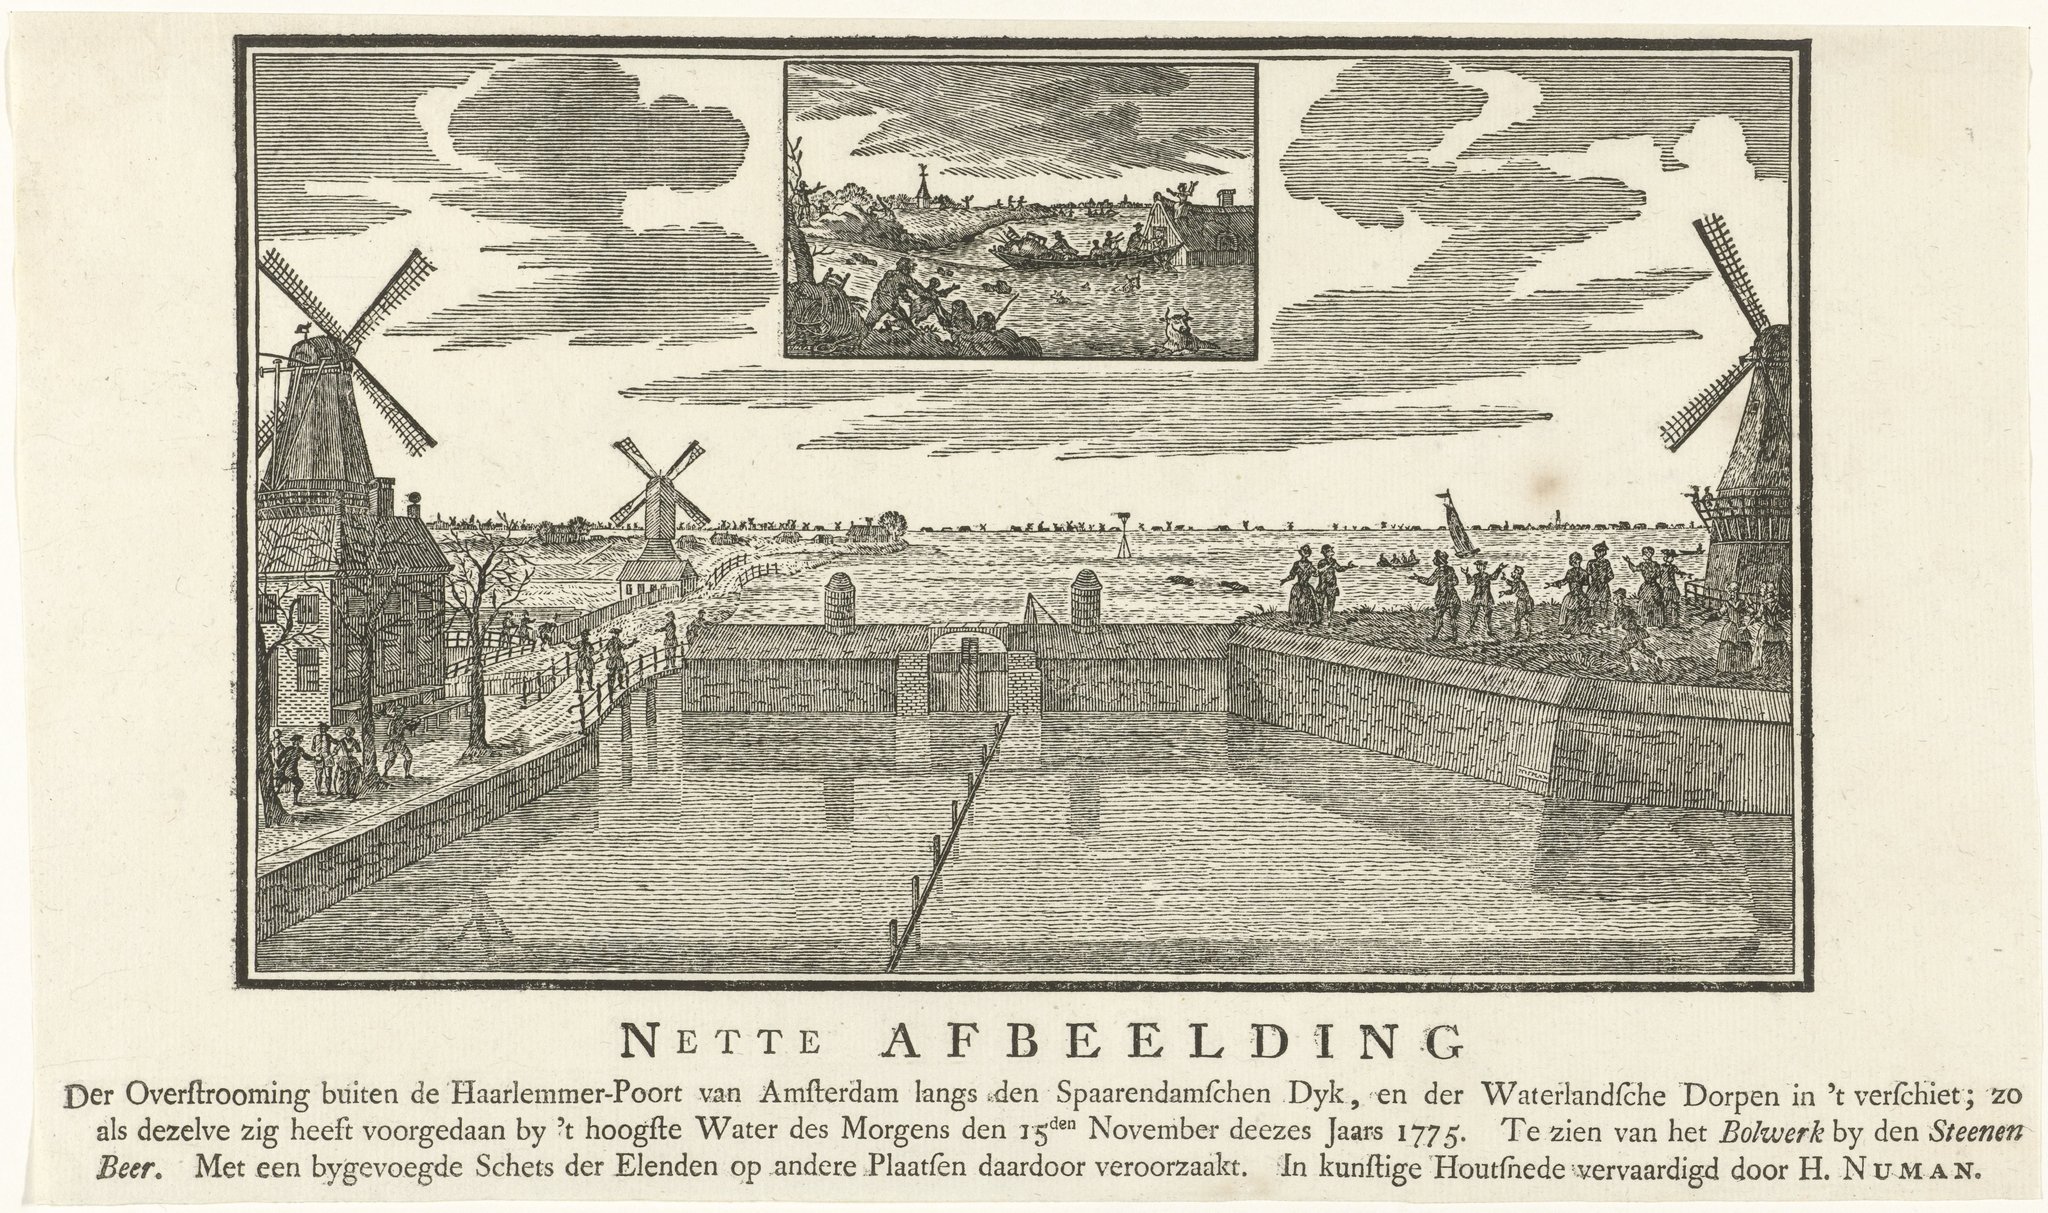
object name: print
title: Overstroming buiten de Haarlemmerpoort, 1775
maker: hendrik numan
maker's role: draughtsman, print maker, publisher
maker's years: 1736-1788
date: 1775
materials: paper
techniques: letterpress printing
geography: northern netherlands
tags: dike-break, the flood of 14-18 november 1775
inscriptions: collector's mark: Lugt 2228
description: Gezicht op het overstroomde land buiten de Haarlemmerpoort te Amsterdam, langs de Spaarndamse Dijk en met de dorpen in Waterland in het verschiet. Gezien vanaf het bolwerk bij de Stenen Beer. In de morgen na de storm op 15 november 1775.